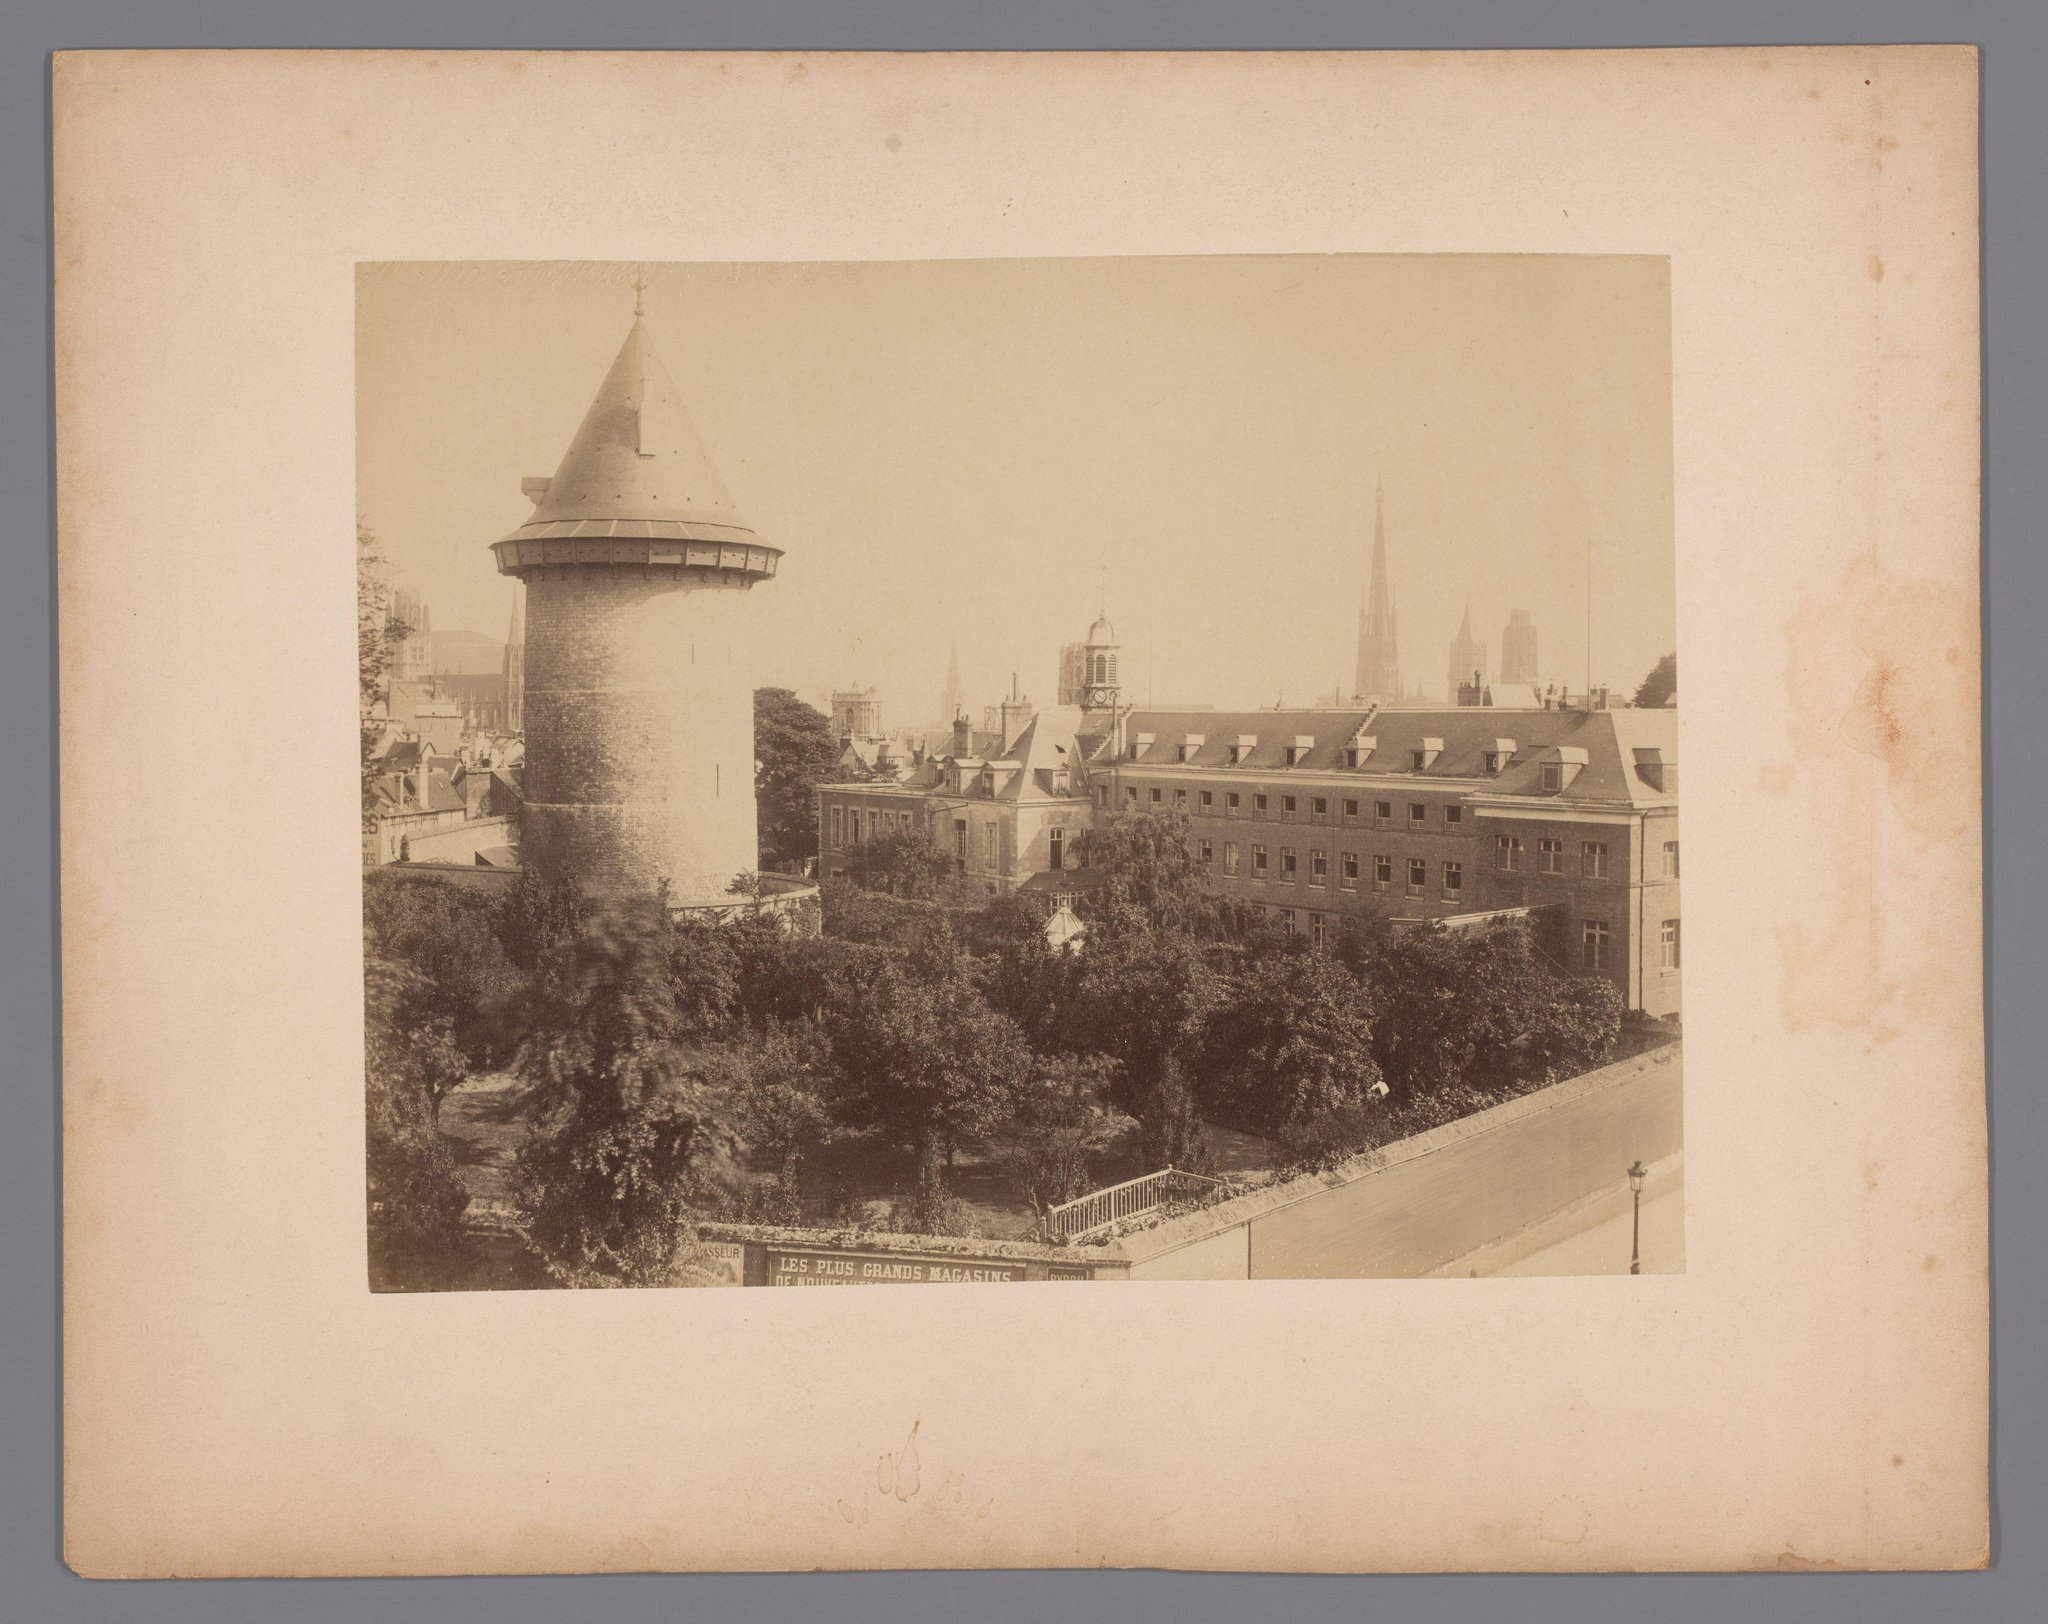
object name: photograph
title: Stadsgezicht met (water)toren en kathedraal, Frankrijk [?]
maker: Anonymous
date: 1880-1900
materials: cardboard, paper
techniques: albumen print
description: Stadsgezicht met (water)toren en kathedraal, Frankrijk [?].